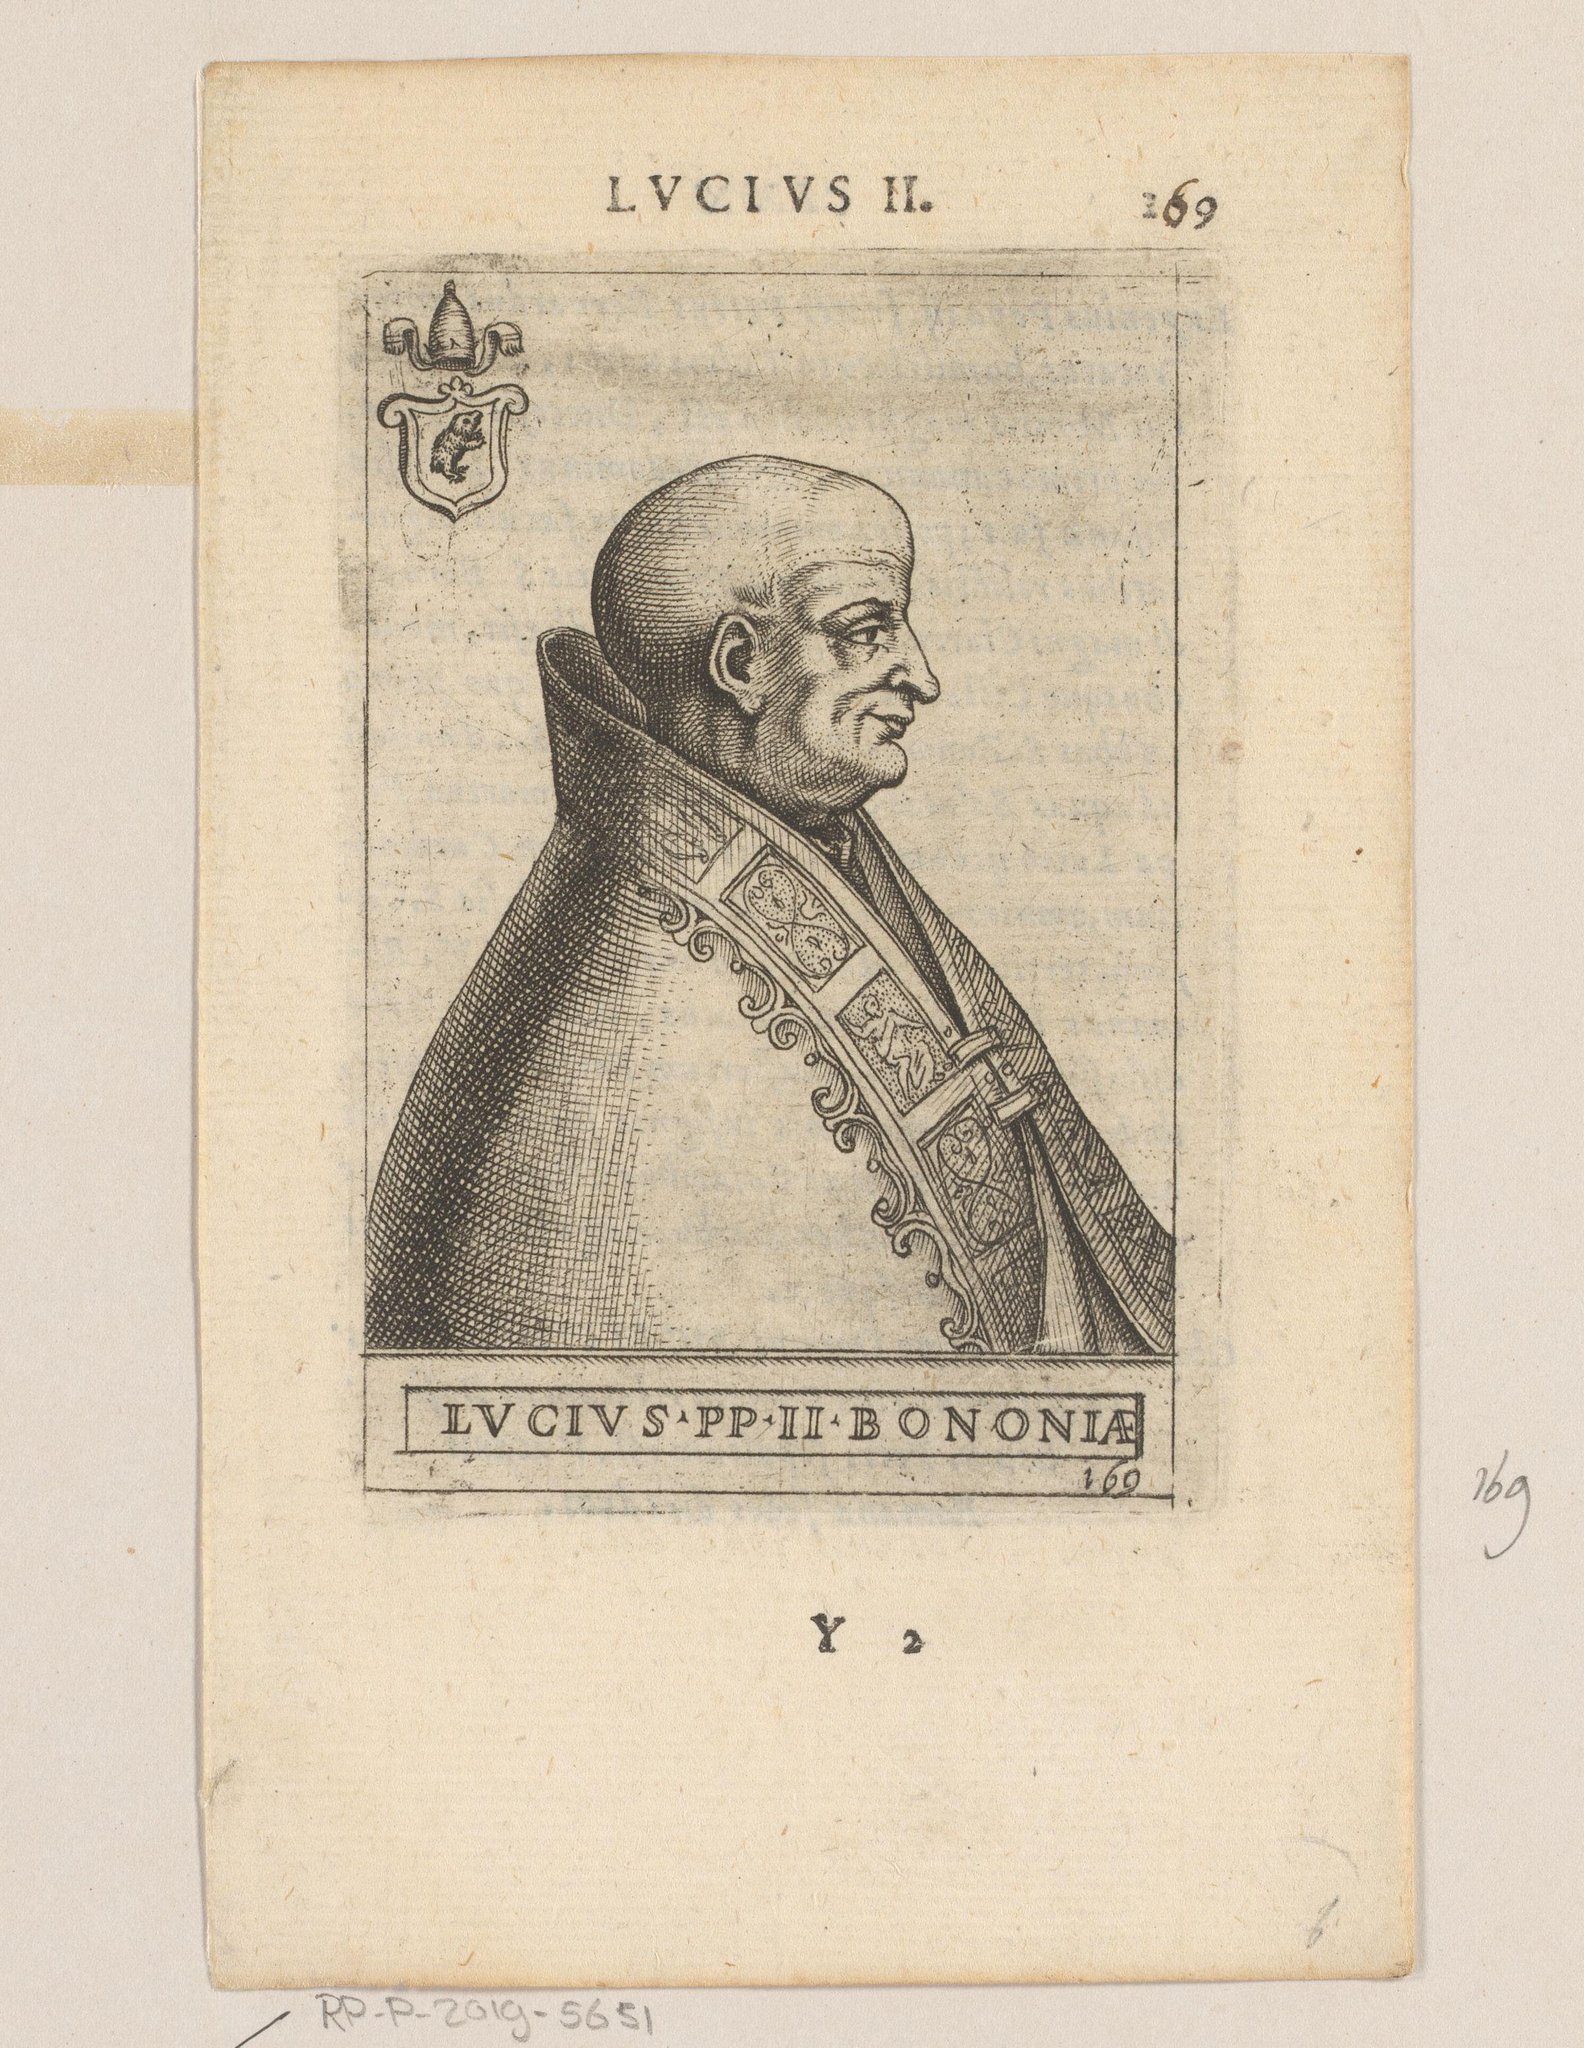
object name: print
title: Lucius PP II Bononiae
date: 1595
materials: paper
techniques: engraving, letterpress printing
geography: rome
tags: historical persons, pope, armorial bearing, heraldry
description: Prent uit: Cavalieri, Giovanni Battista de'. Effigies pontificum romanorum cum eorum vitis (...). Rome: Bartolomeo Bonfadino, 1595. Prent voor het eerst verschenen in: Cavalieri, Giovanni Battista de'. Pontificum romanorum effigies (...). Rome: Domenico Basa en Francesco Zanetti, 1580. Prent ook gebruikt in latere publicaties.